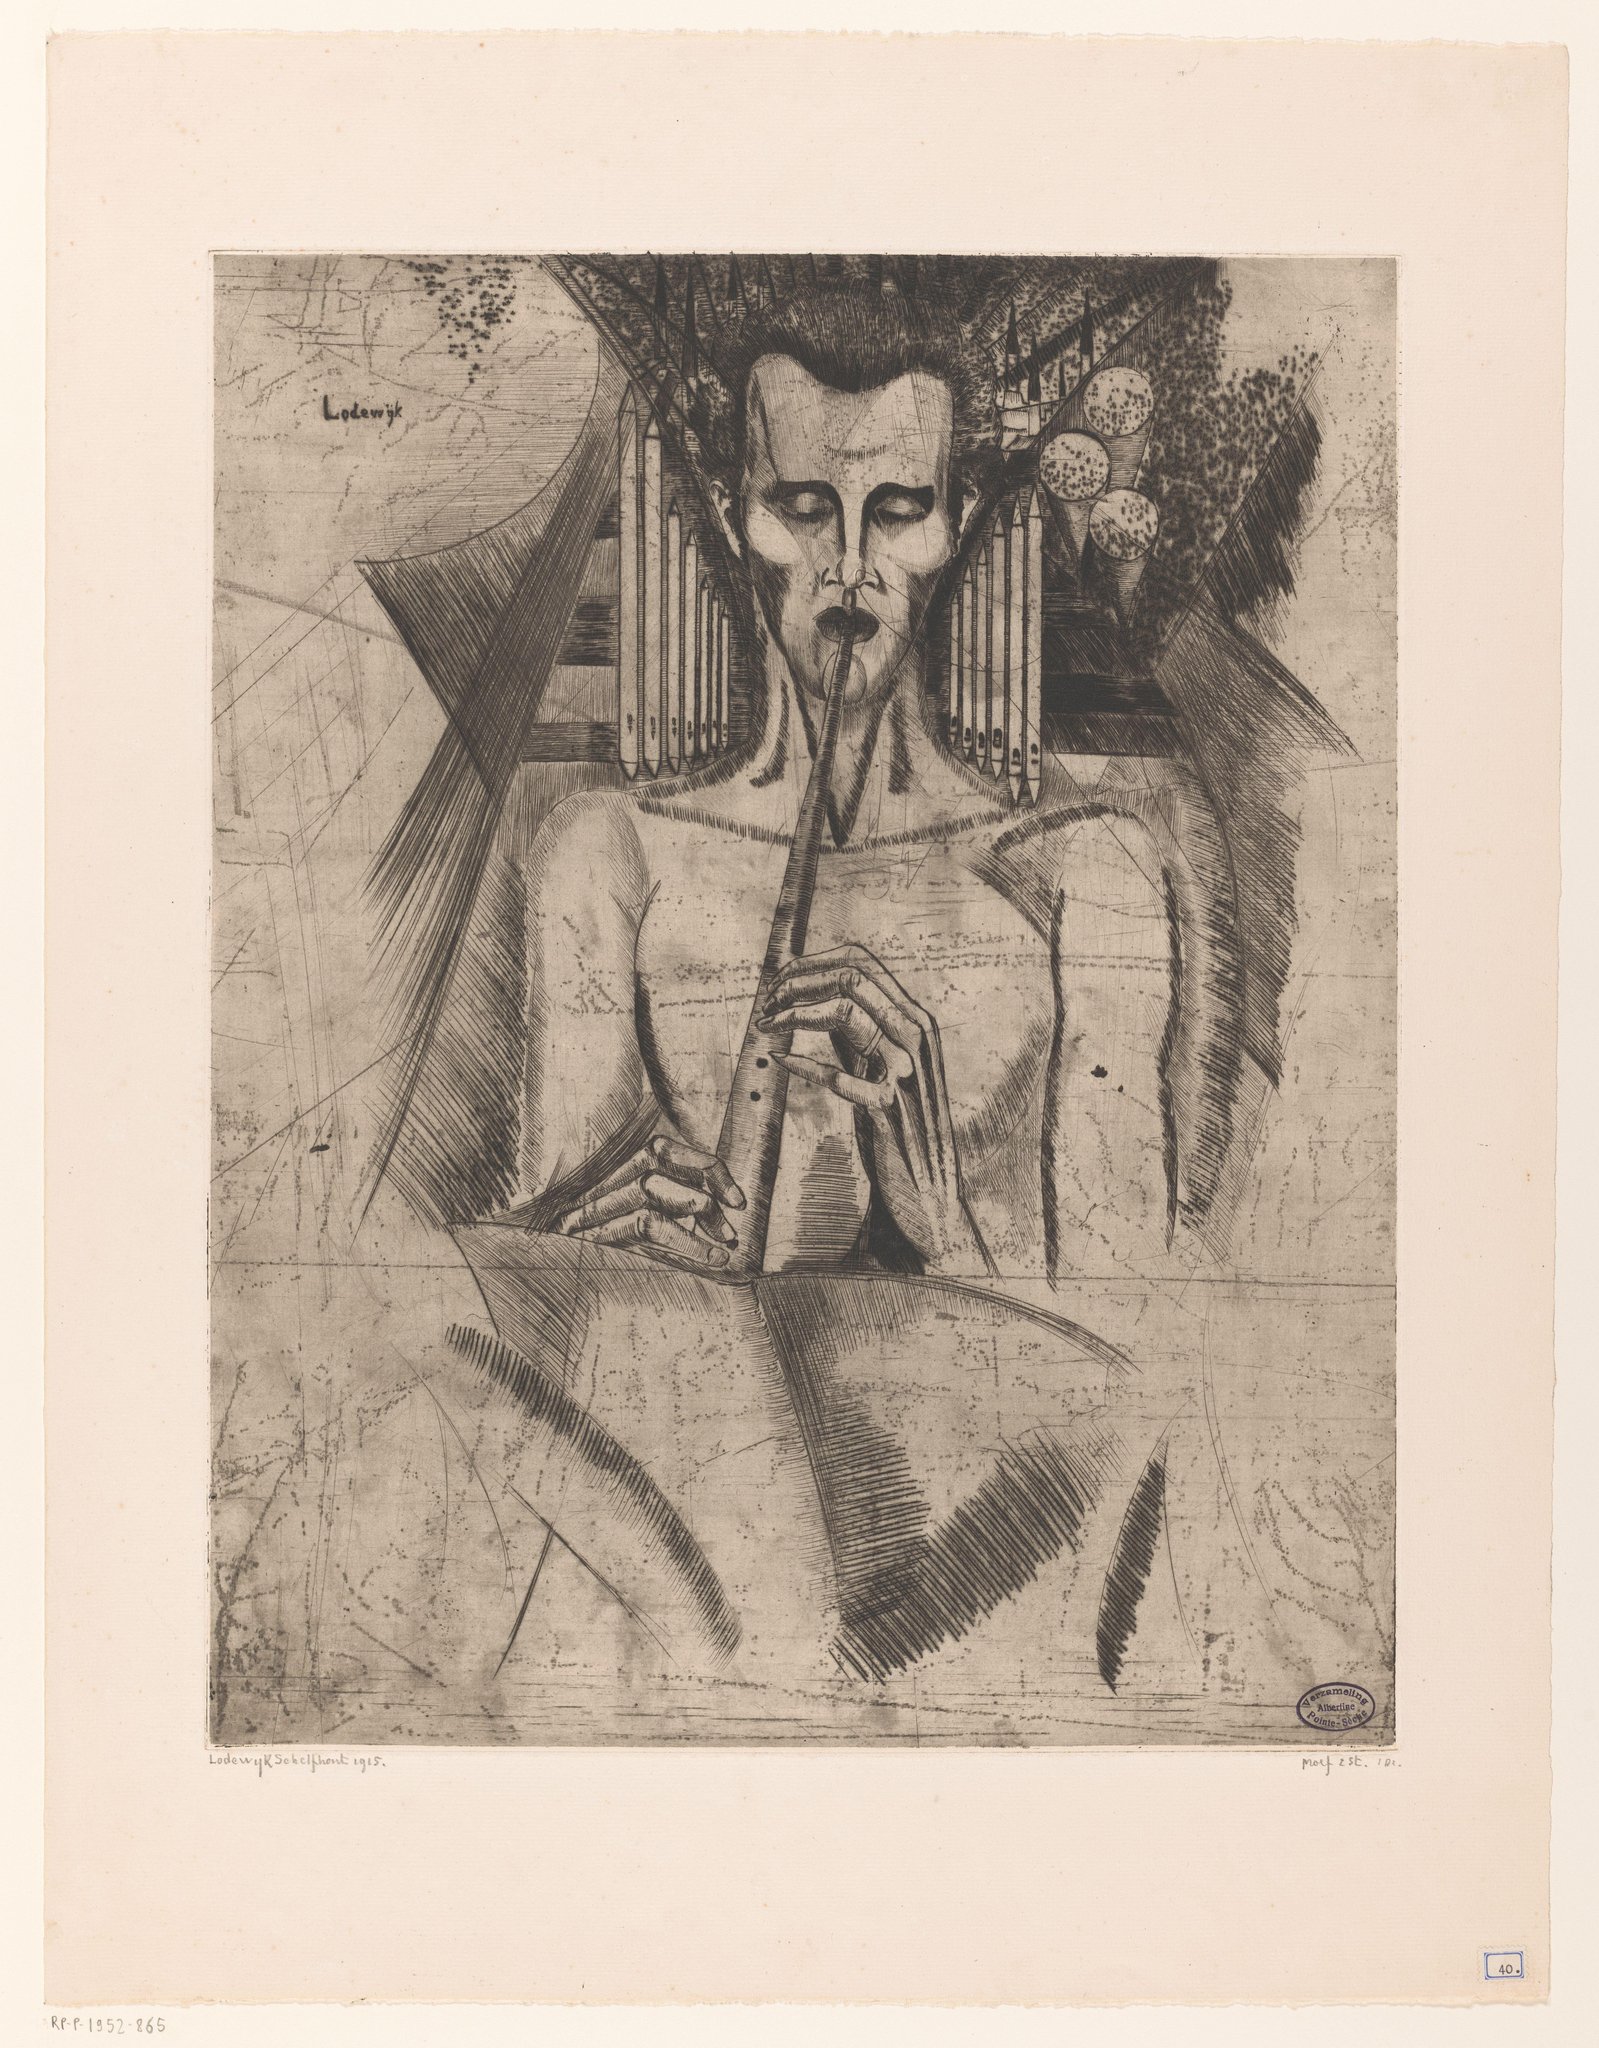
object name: print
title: Naakte man die een fluit bespeelt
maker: lodewijk schelfhout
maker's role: draughtsman, print maker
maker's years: 1881-1943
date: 1915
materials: paper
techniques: drypoint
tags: flute, aulos, tibia, man (showing himself) undressed, quasi-nude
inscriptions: collector's mark: Lugt 2760, collector's mark: Lugt 5i, collector's mark: Lugt 2228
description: Op de achtergrond een orgel en een gebouw met torens.